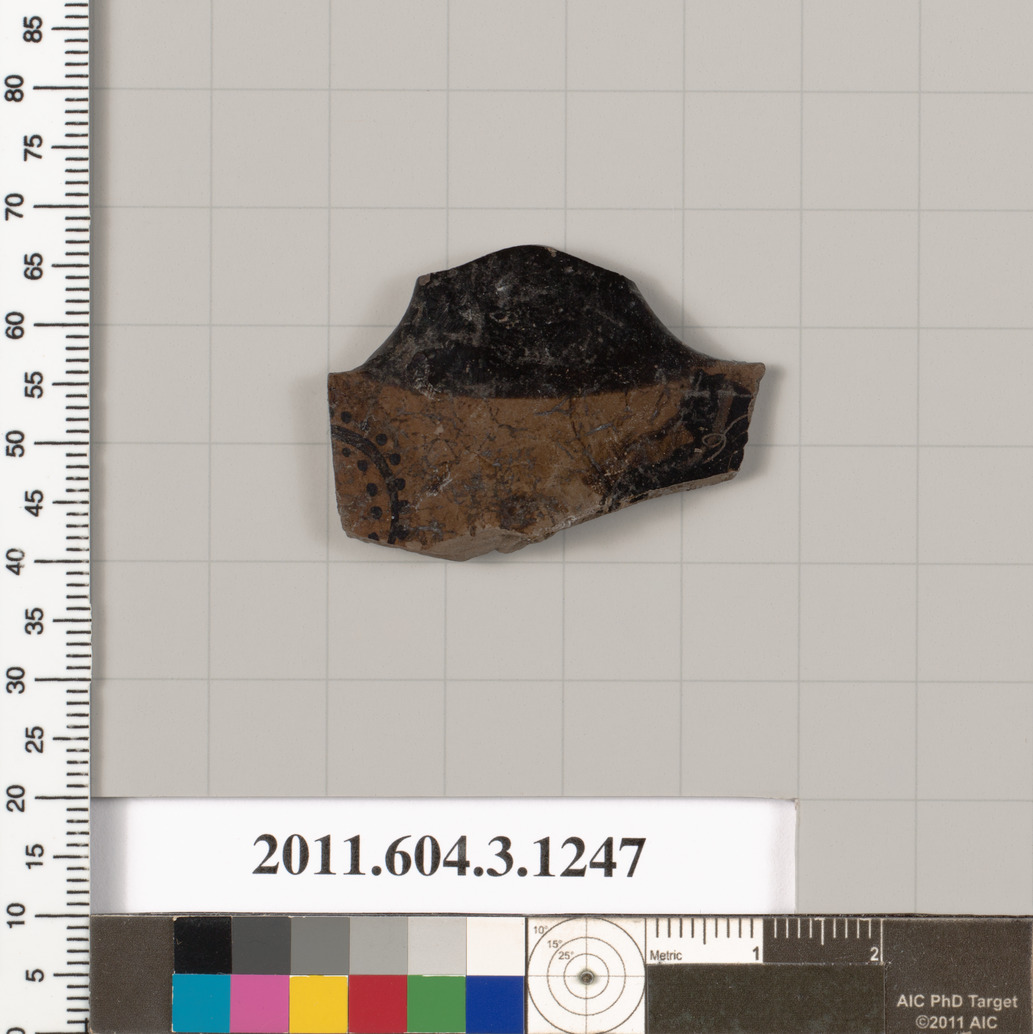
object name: kyathos fragment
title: Terracotta fragment of a kyathos (cup-shaped ladle)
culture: greek, attic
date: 534-468 BCE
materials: terracotta